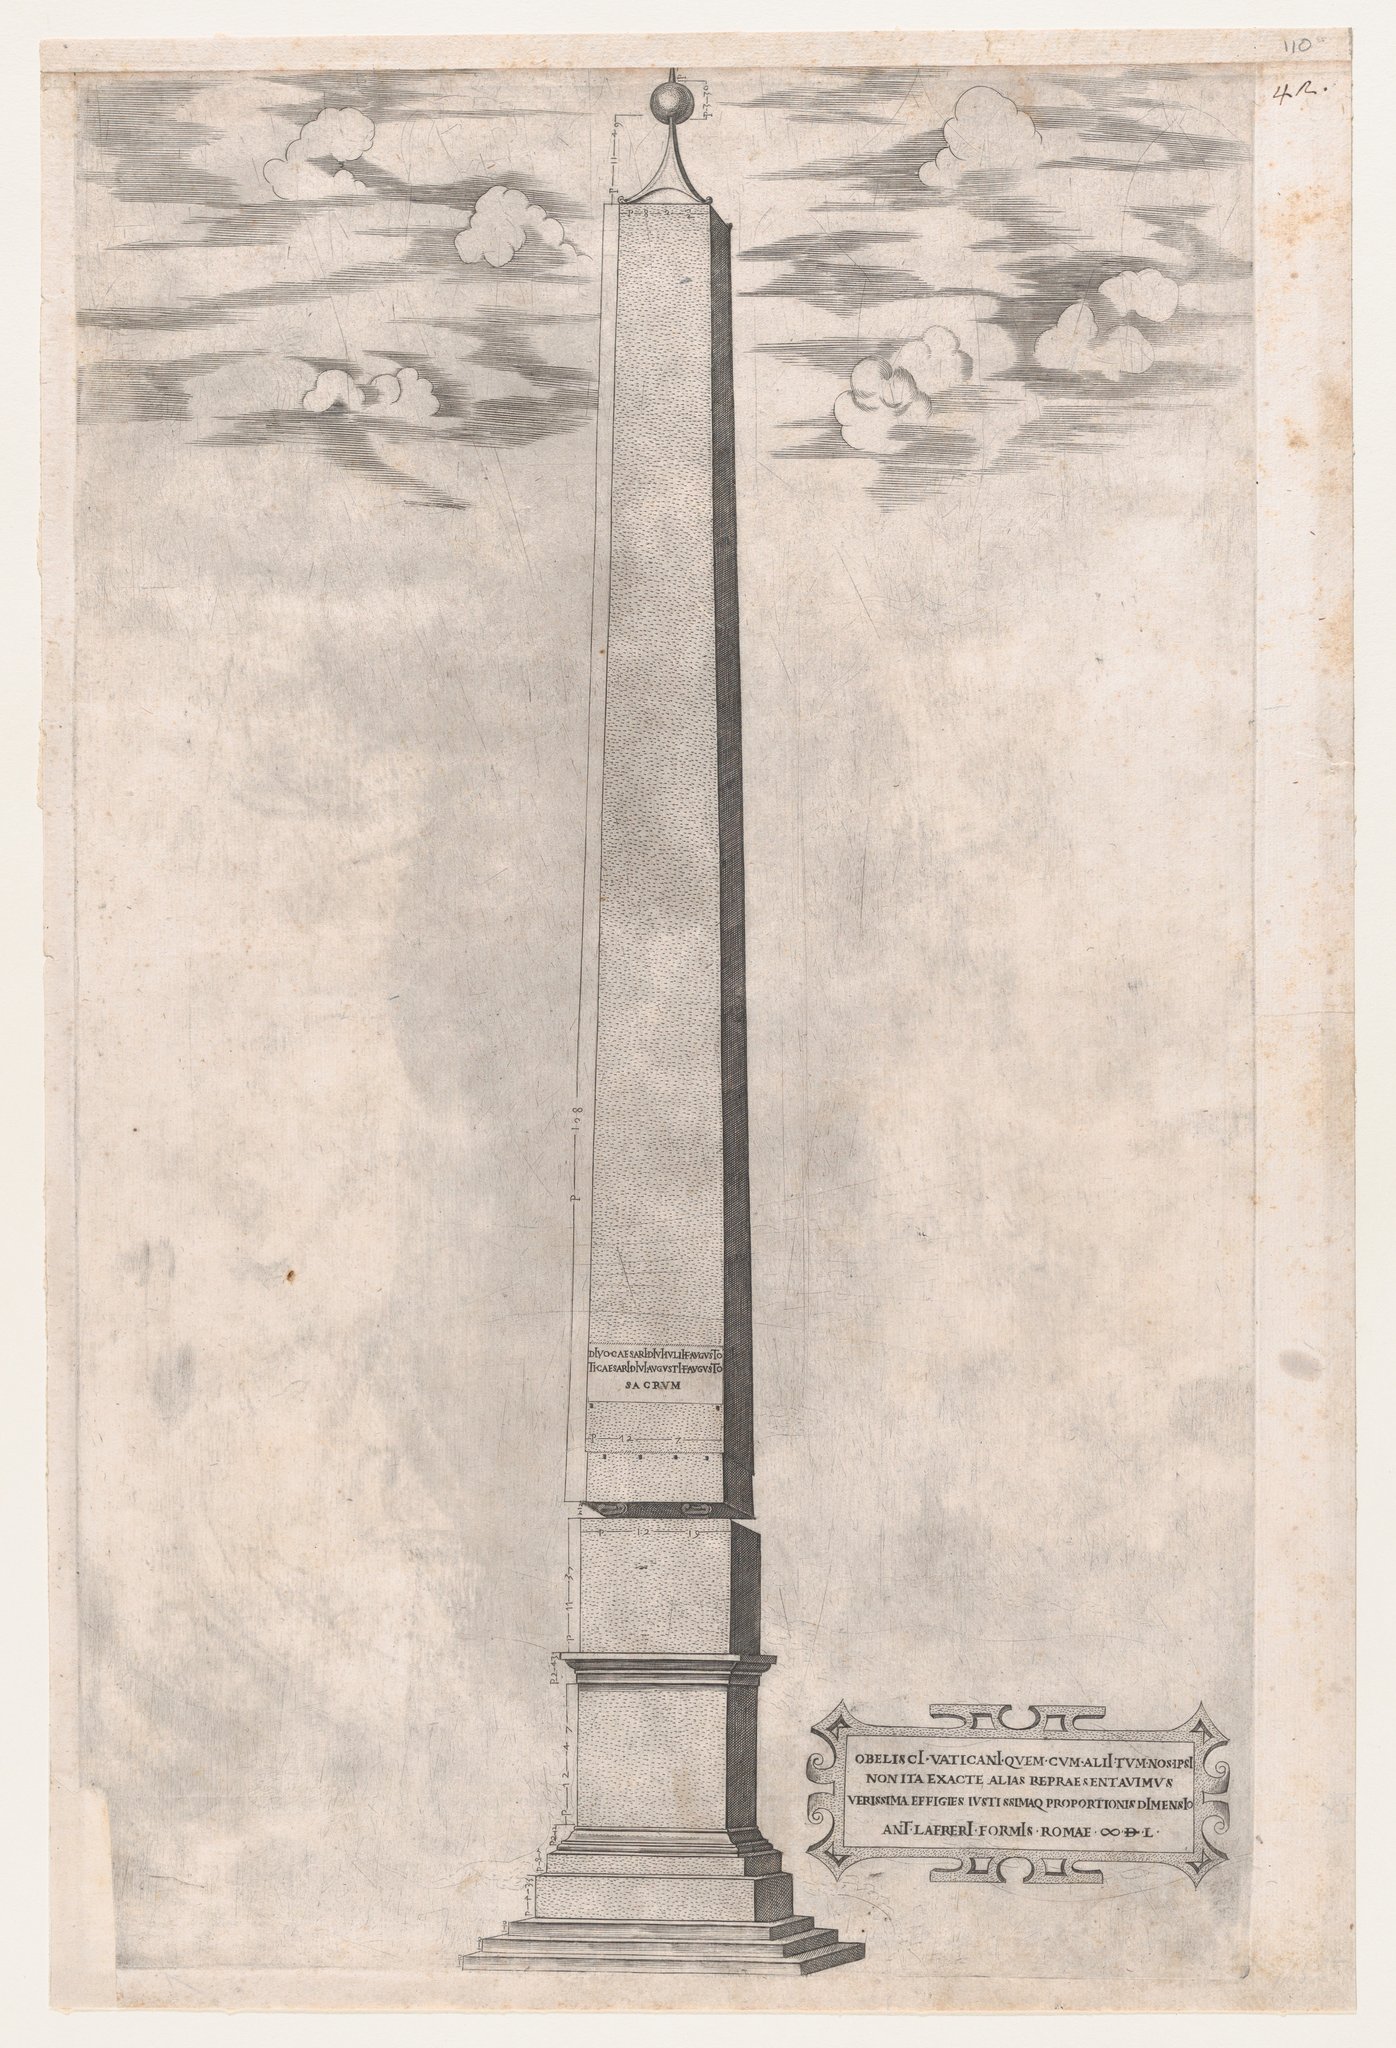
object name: print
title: The Vatican Obelisque, from "Speculum Romanae Magnificentiae"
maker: Anonymous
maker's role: artist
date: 1550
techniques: engraving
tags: obelisks,rome